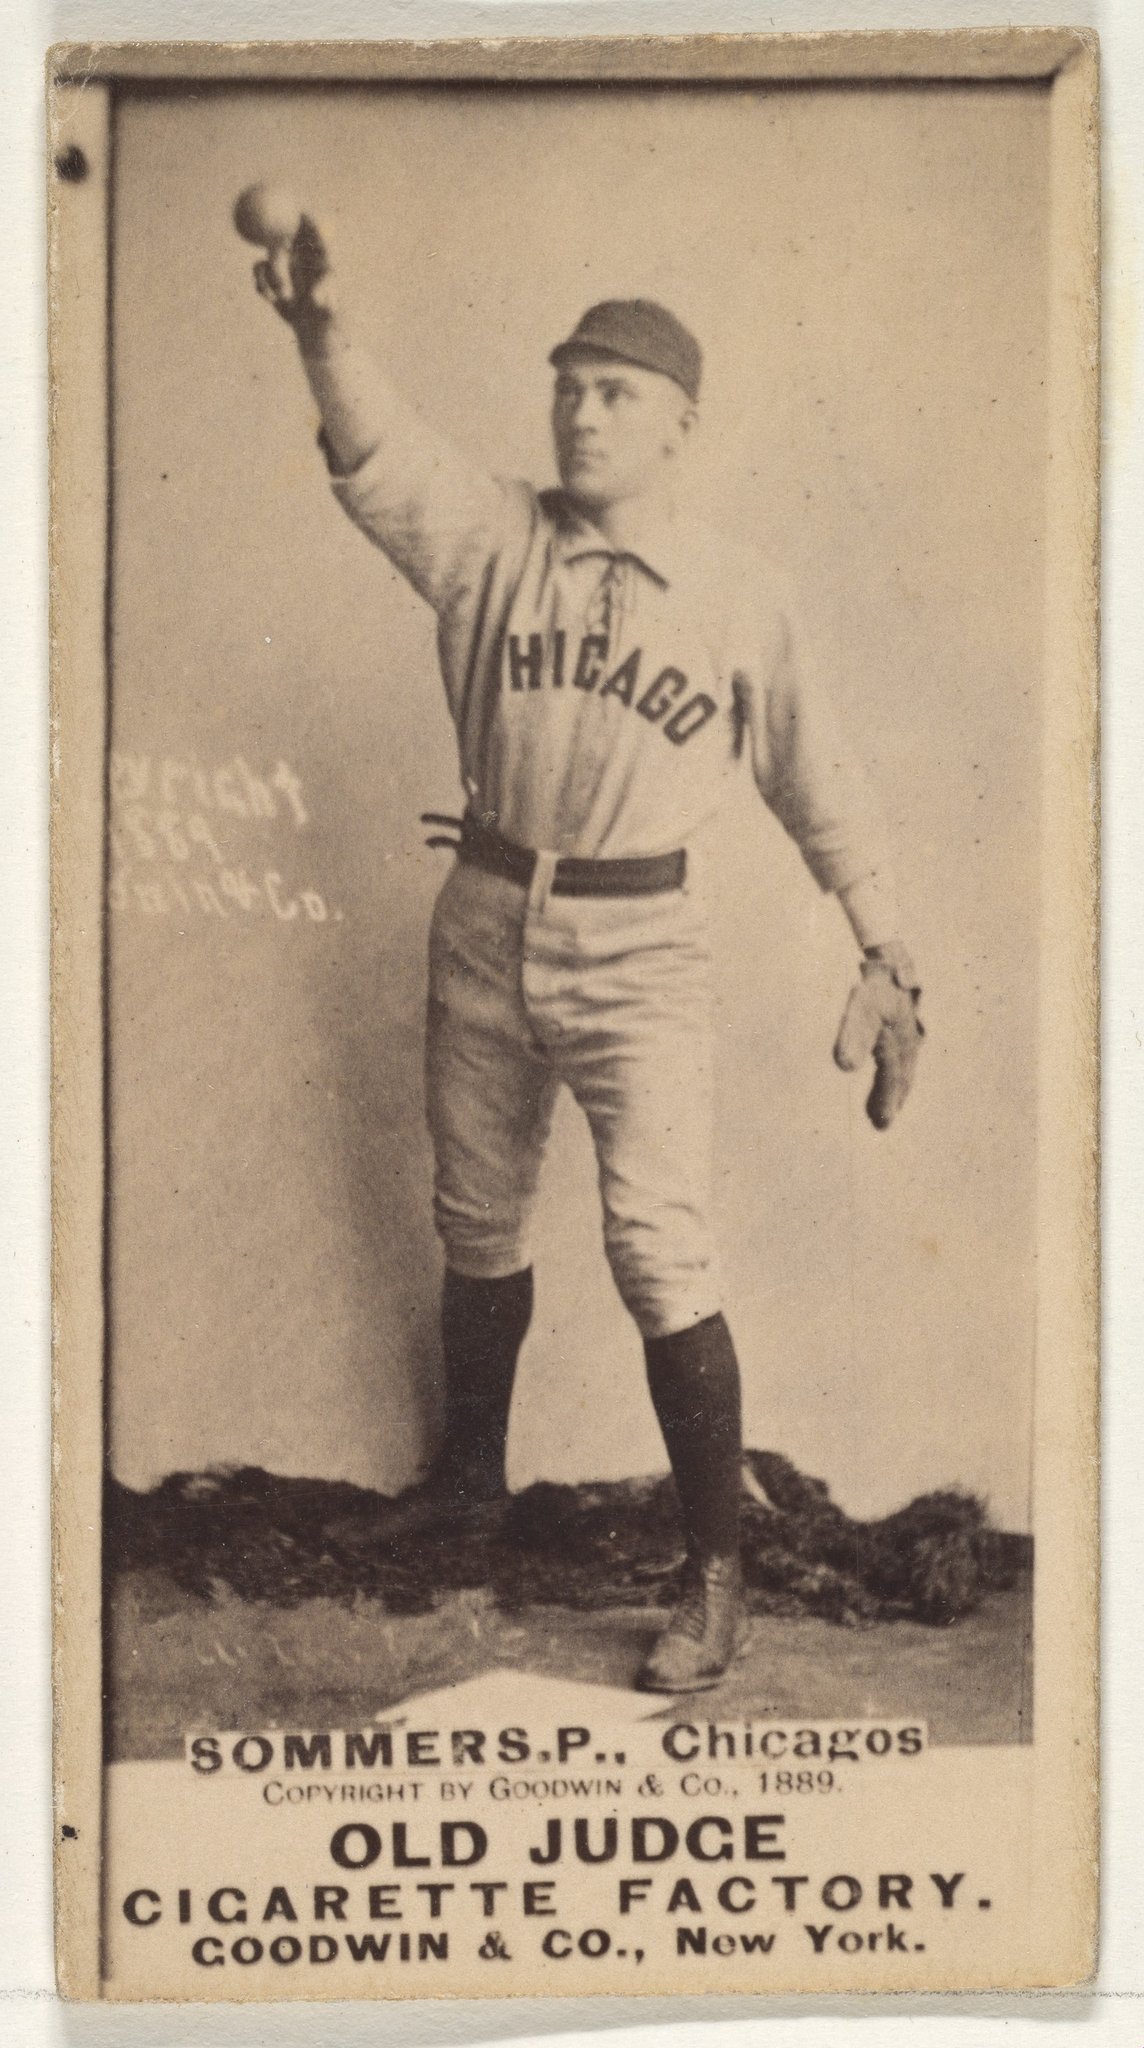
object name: baseball card, photograph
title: Sommers, Catcher, Chicago, from the Old Judge series (N172) for Old Judge Cigarettes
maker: goodwin & company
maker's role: publisher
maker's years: 1850-1950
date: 1889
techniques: albumen silver print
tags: men,portraits,baseball,athletes